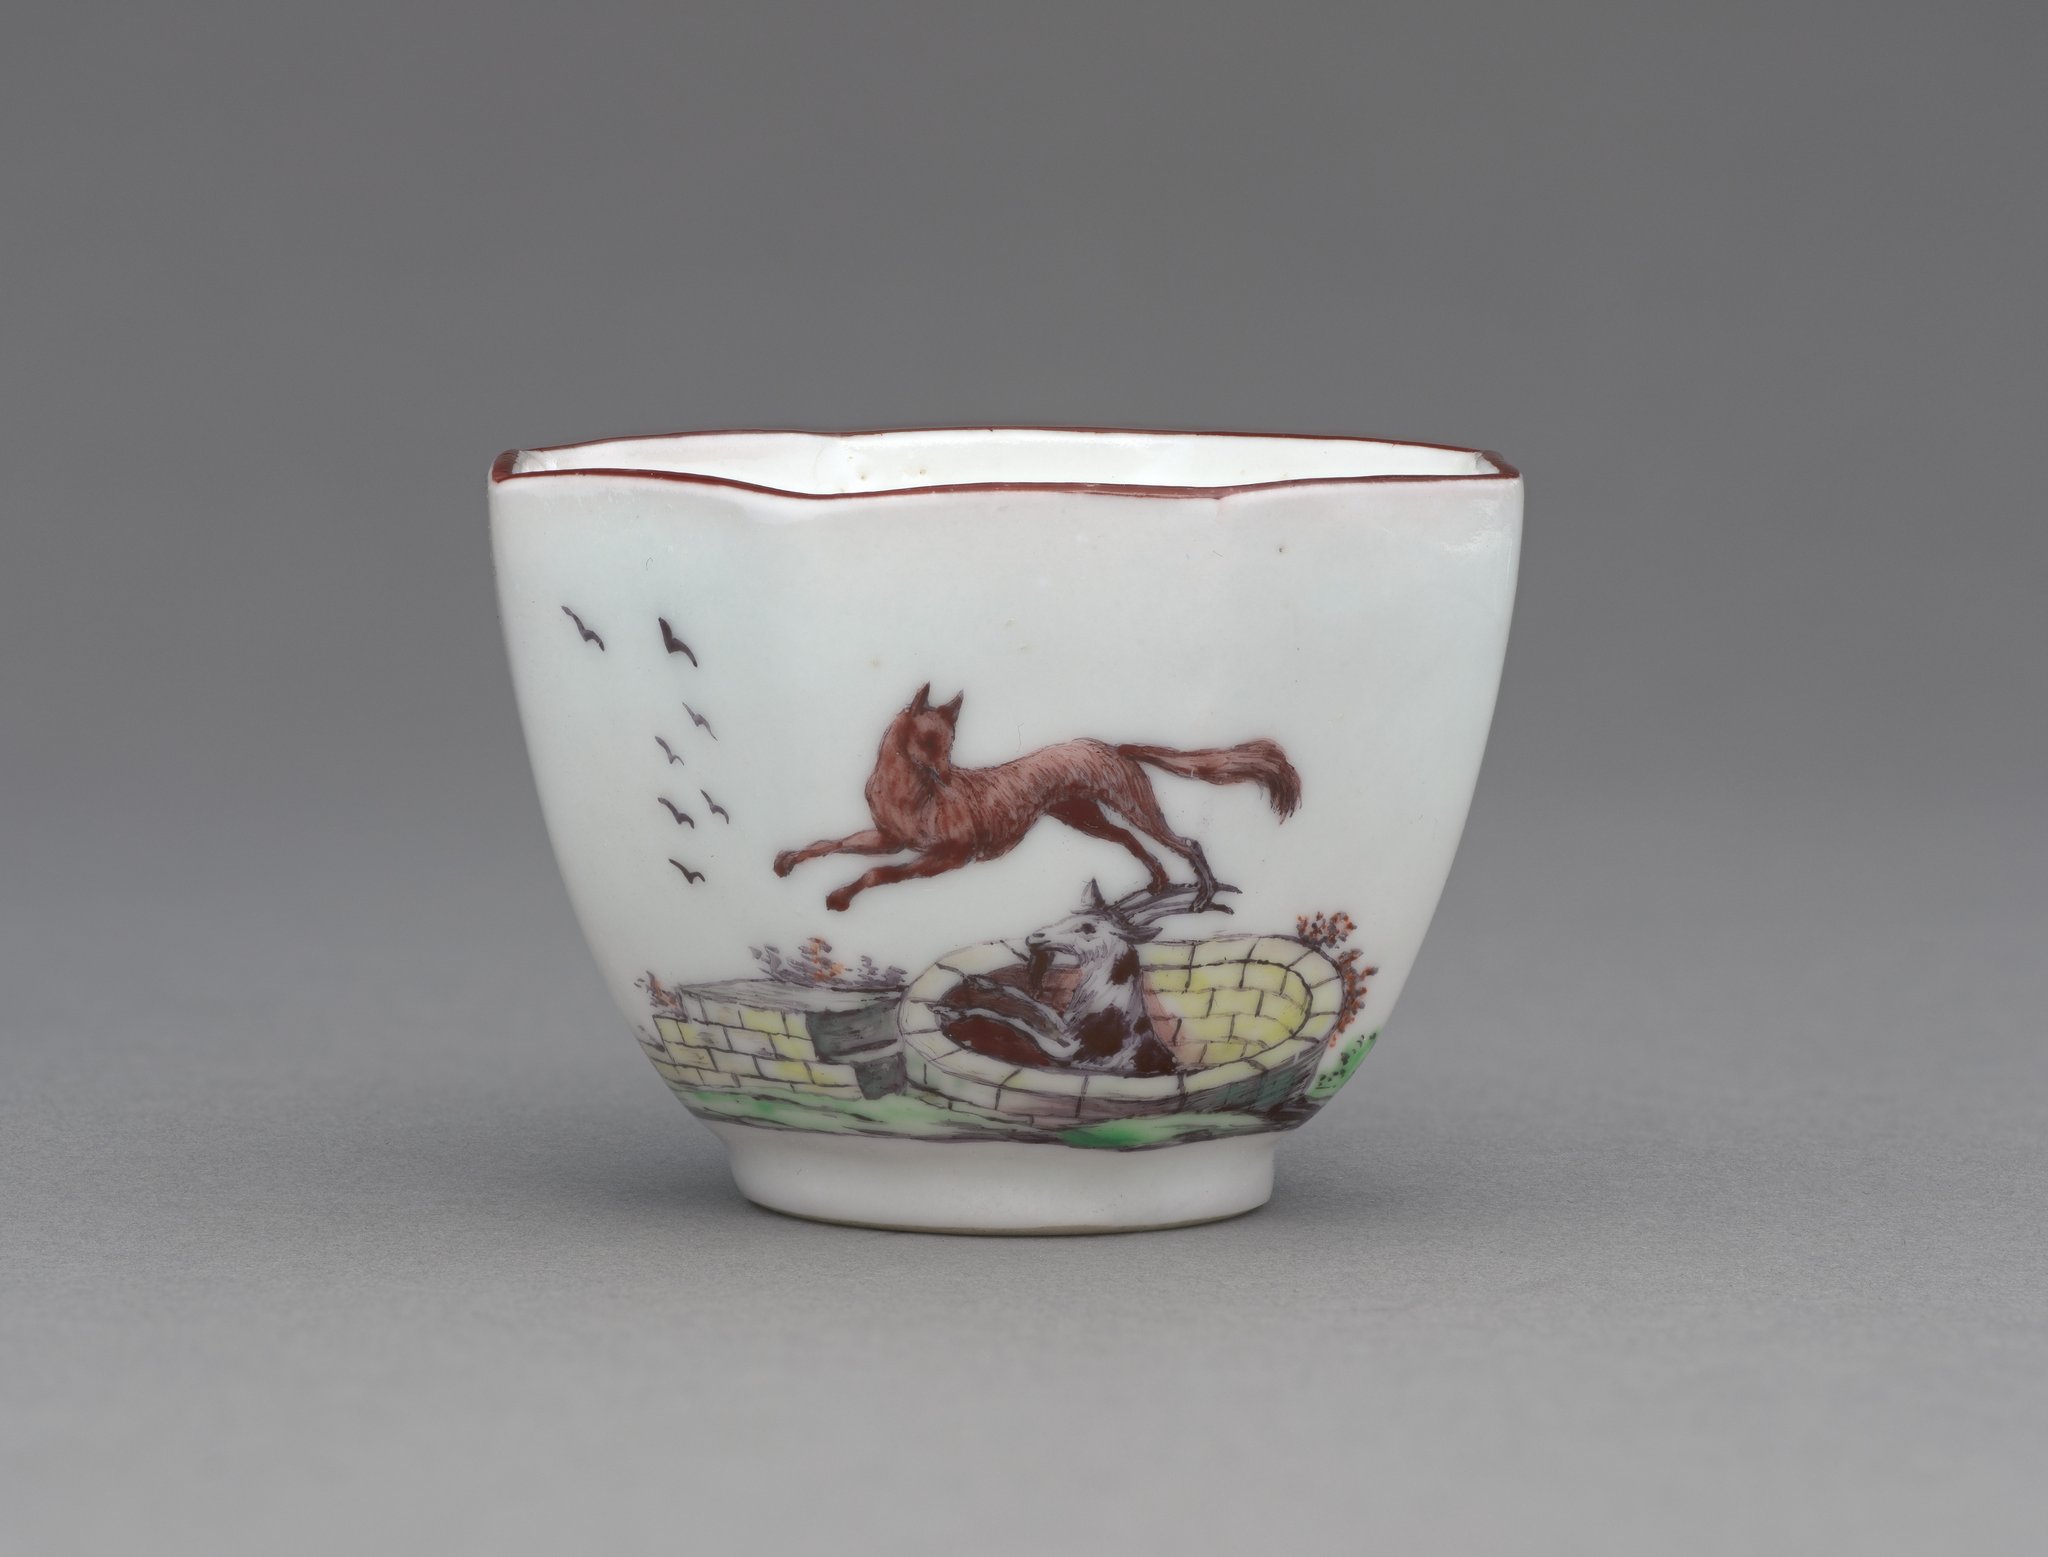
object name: beaker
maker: chelsea porcelain manufactory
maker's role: factory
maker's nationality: british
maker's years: 1744-1784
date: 1752-1755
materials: soft paste porcelain